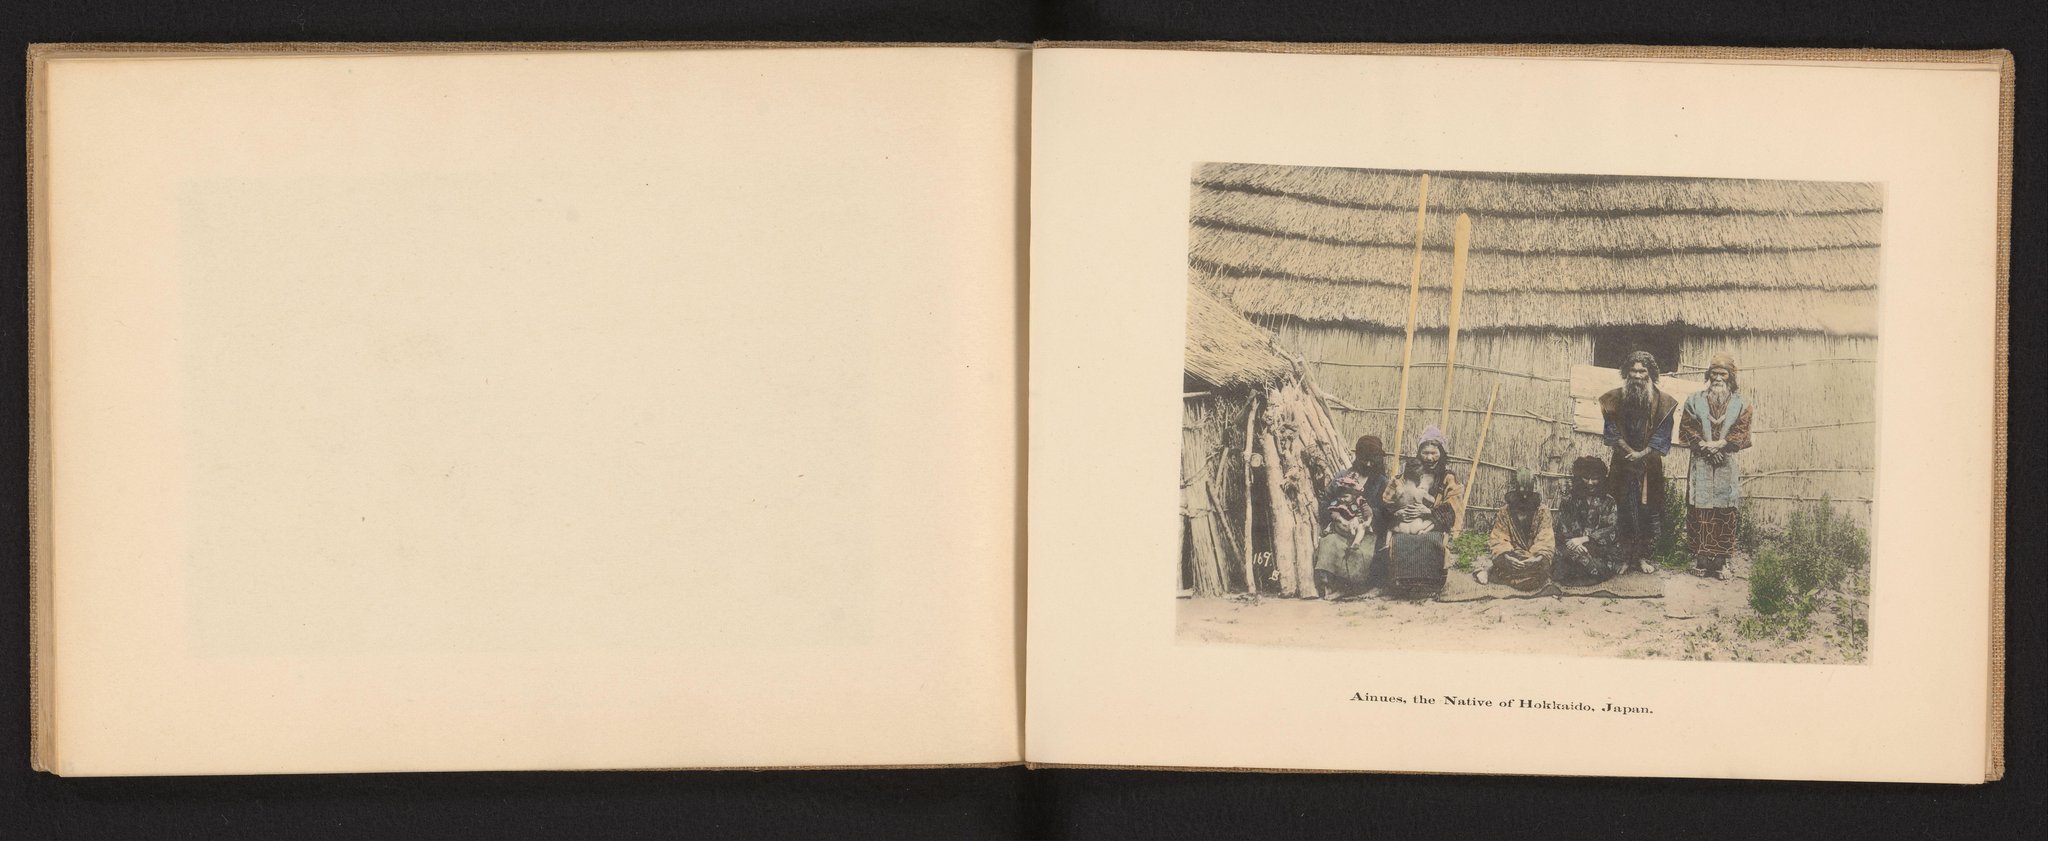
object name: photomechanical print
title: Portret van onbekende mensen van de Aino voor een huis in Japan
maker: kōzaburō tamamura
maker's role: fotograaf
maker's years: 1856-1923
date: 1895-1905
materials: paper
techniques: photograph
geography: japan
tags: human types; peoples and nationalities, japan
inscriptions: number: ‘169.B’